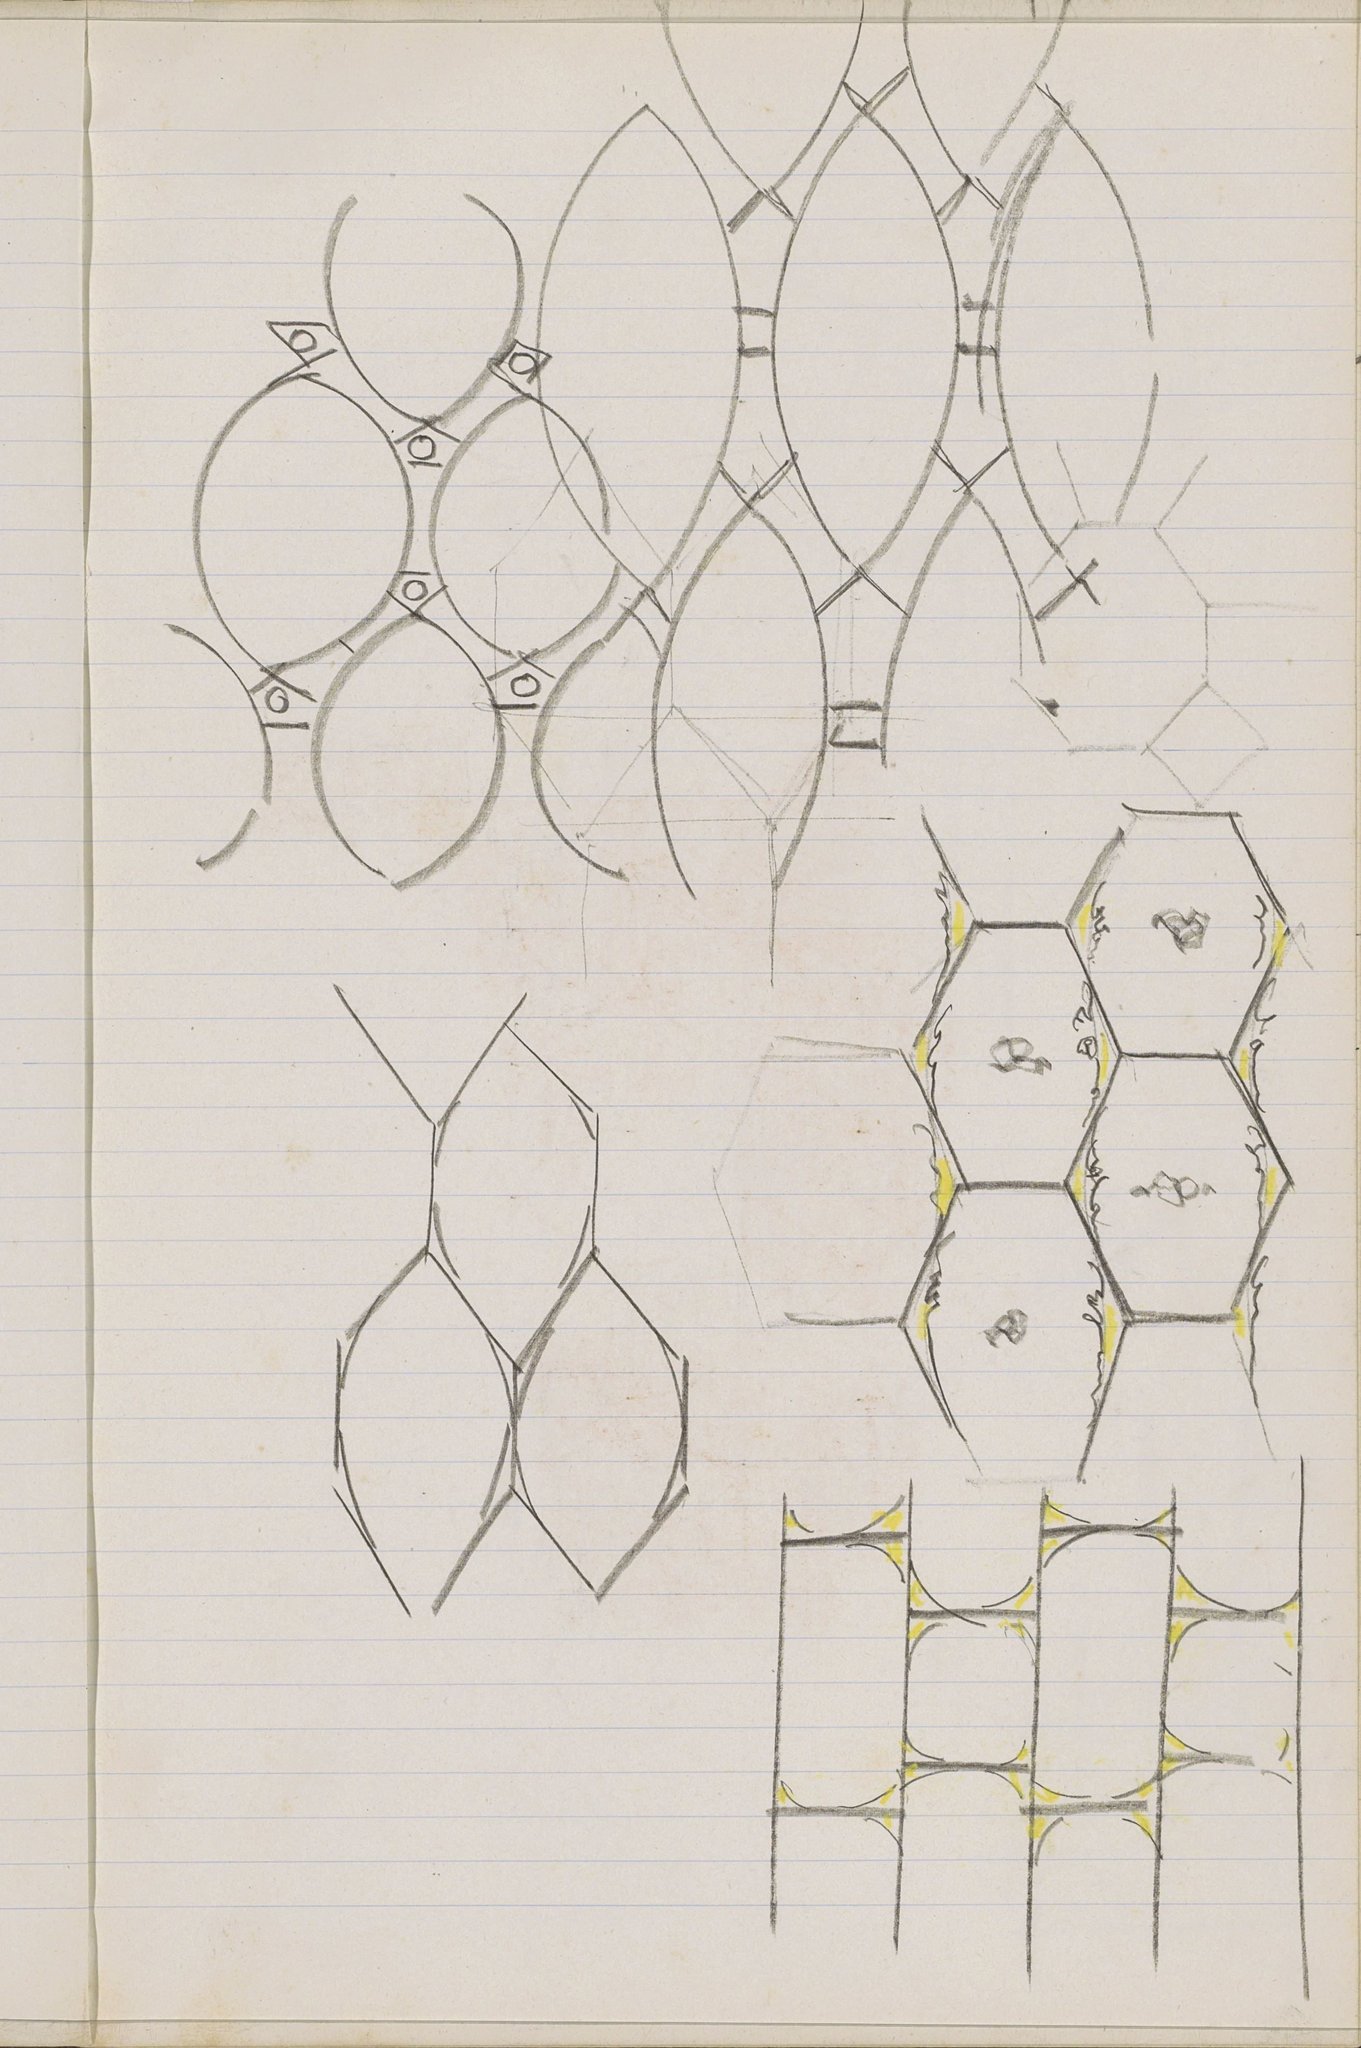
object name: sketchbook leaf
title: Decoratieve patronen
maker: gerrit willem dijsselhof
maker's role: designer, draughtsman, print maker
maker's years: 1866-1924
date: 1901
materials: chalk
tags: ornaments ~ art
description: Blad 34 recto uit een schetsboek met 79 bladen.